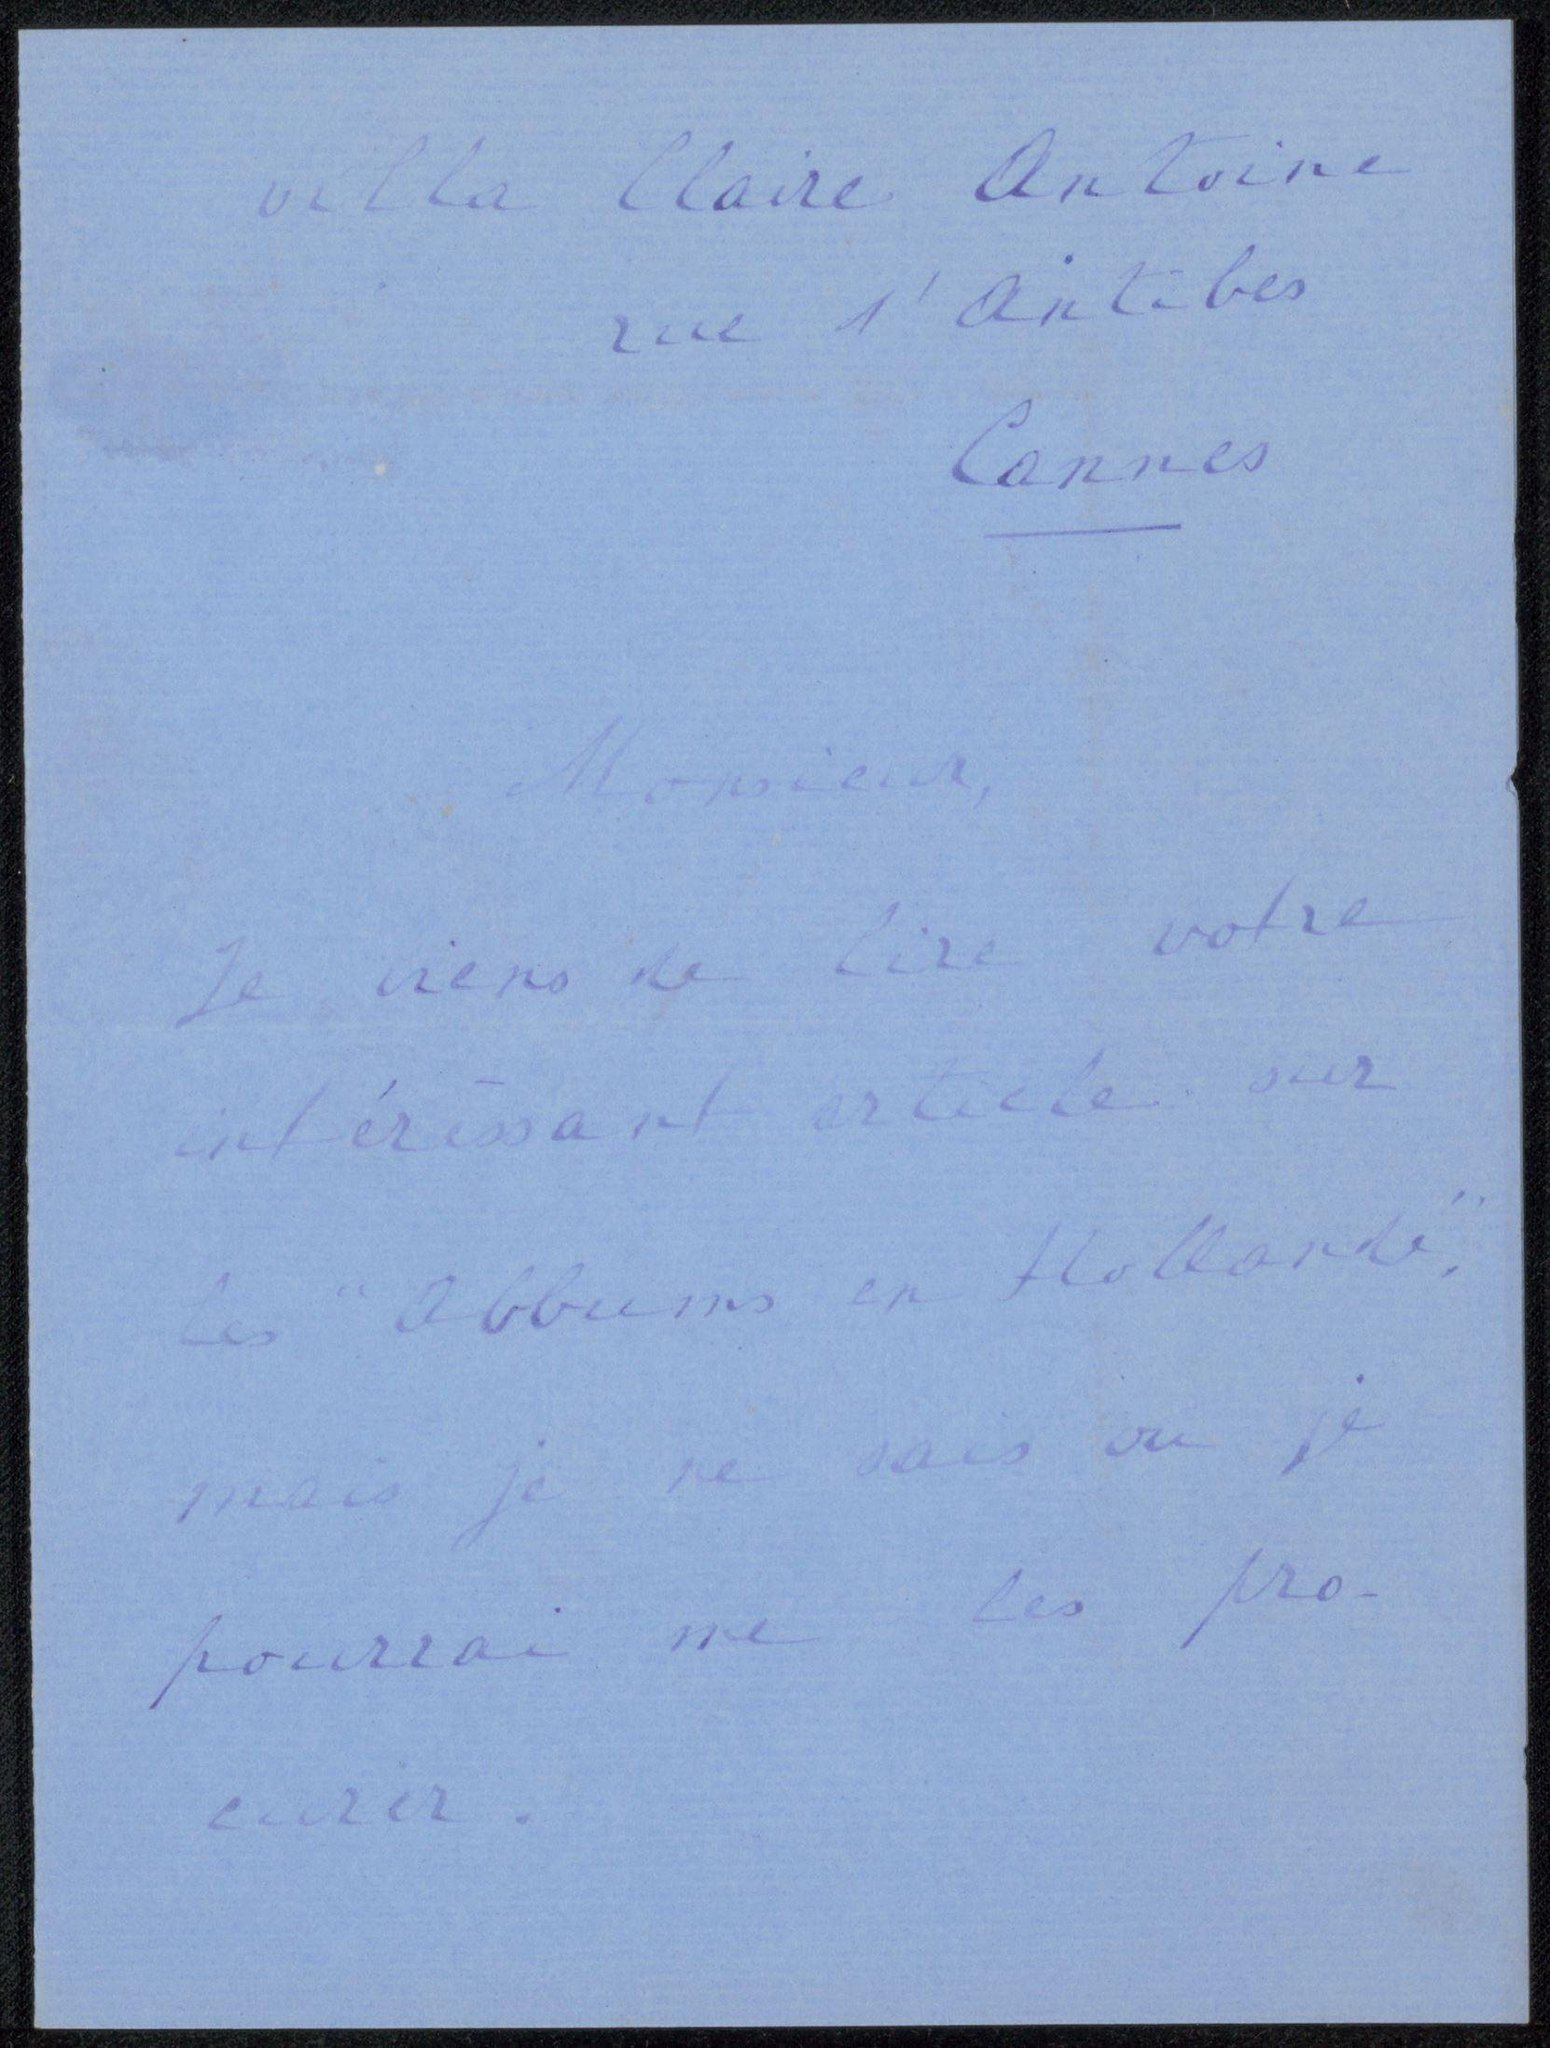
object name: letter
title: Brief aan Philip Zilcken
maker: remy salavator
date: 1898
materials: ink, paper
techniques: pen, writing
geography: cannes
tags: the hague, painter, draughtsman, philip zilcken, literature ~ arts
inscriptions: watermark, collector's mark: ‘RPK’